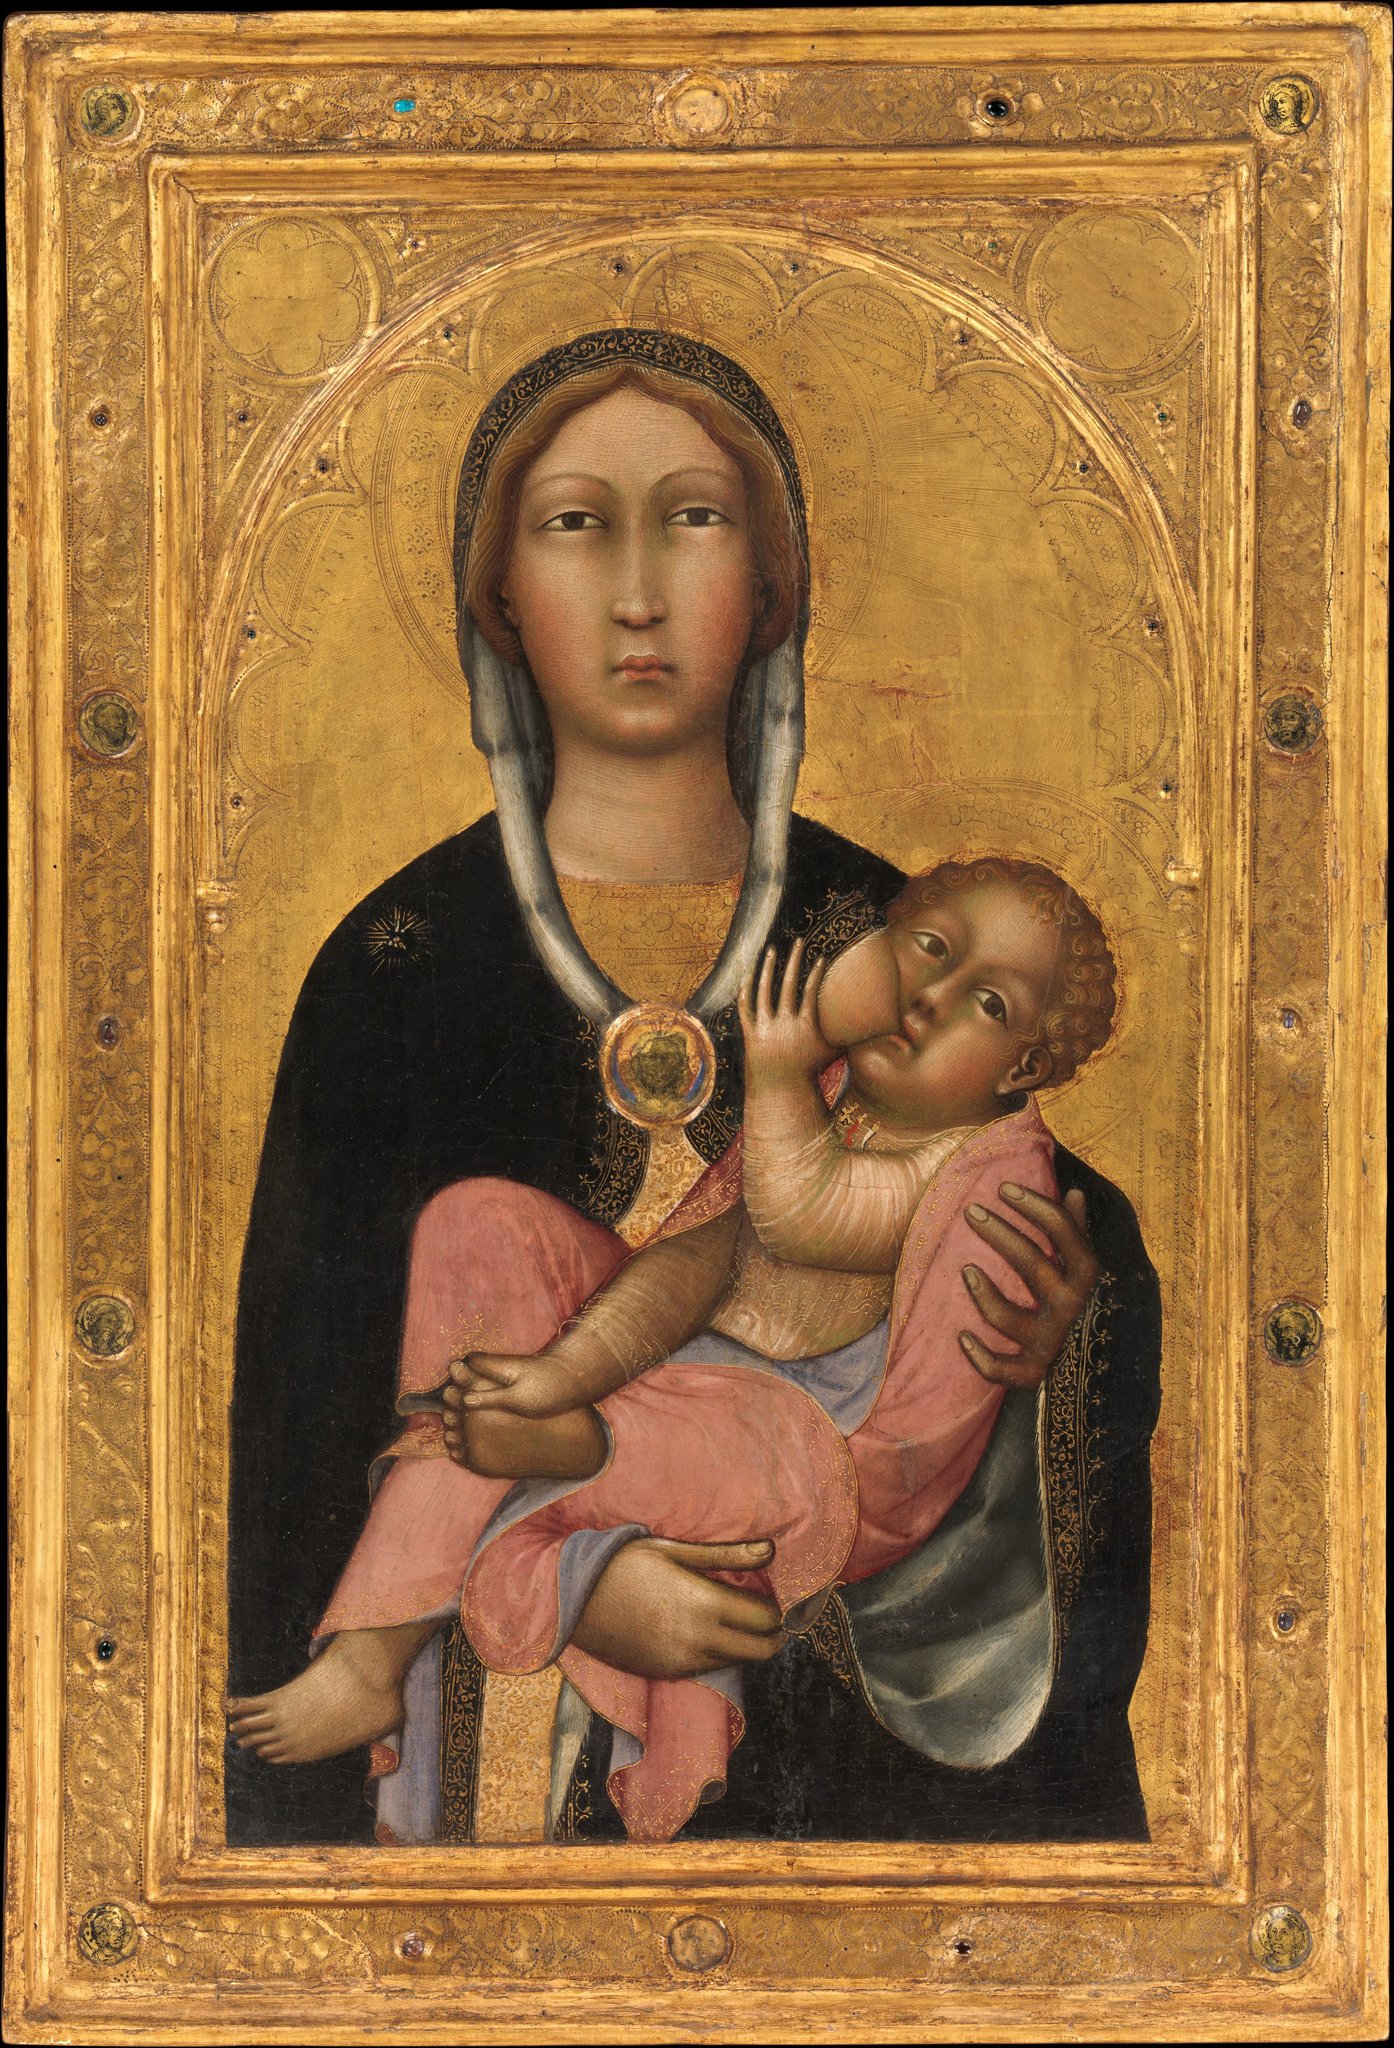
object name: painting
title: Madonna and Child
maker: paolo di giovanni fei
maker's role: artist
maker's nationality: italian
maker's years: 1369-1411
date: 1370-1379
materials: gold leaf, paint, wood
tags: madonna and child,nursing